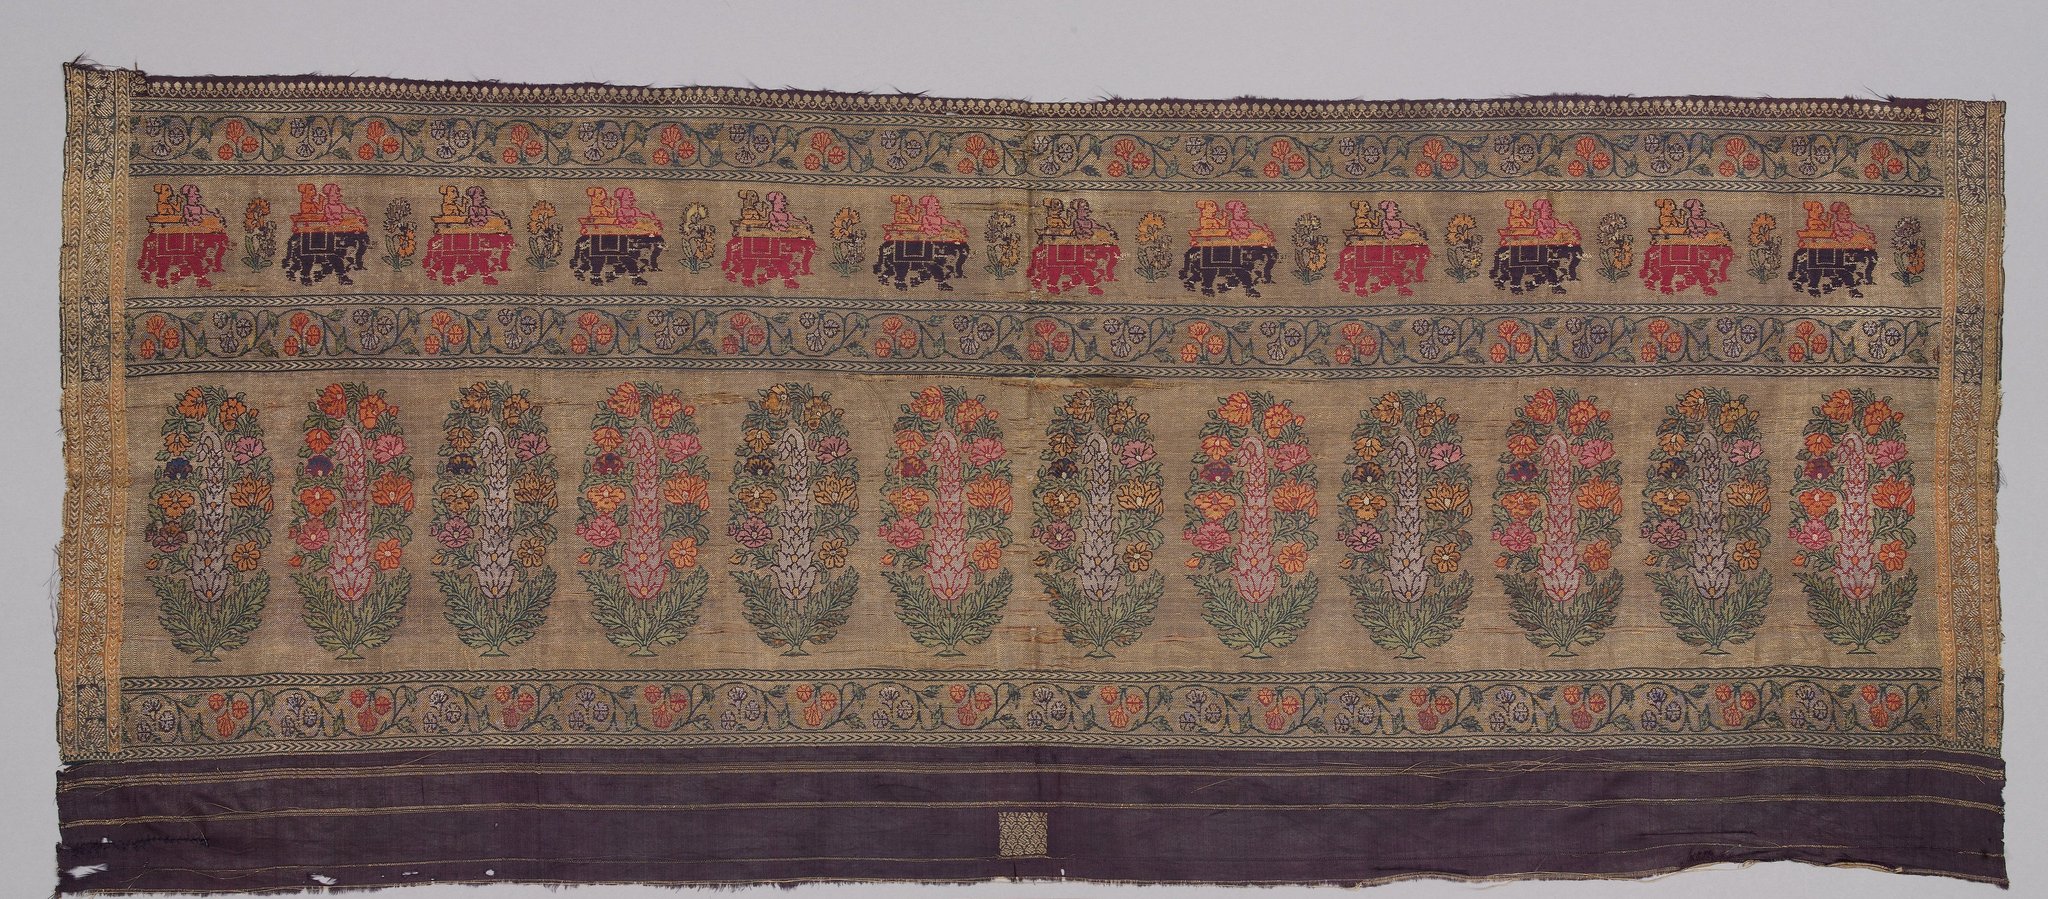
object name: sari border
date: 1601-1700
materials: metal thread, silk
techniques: brocade, weave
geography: india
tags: elephants,flowers